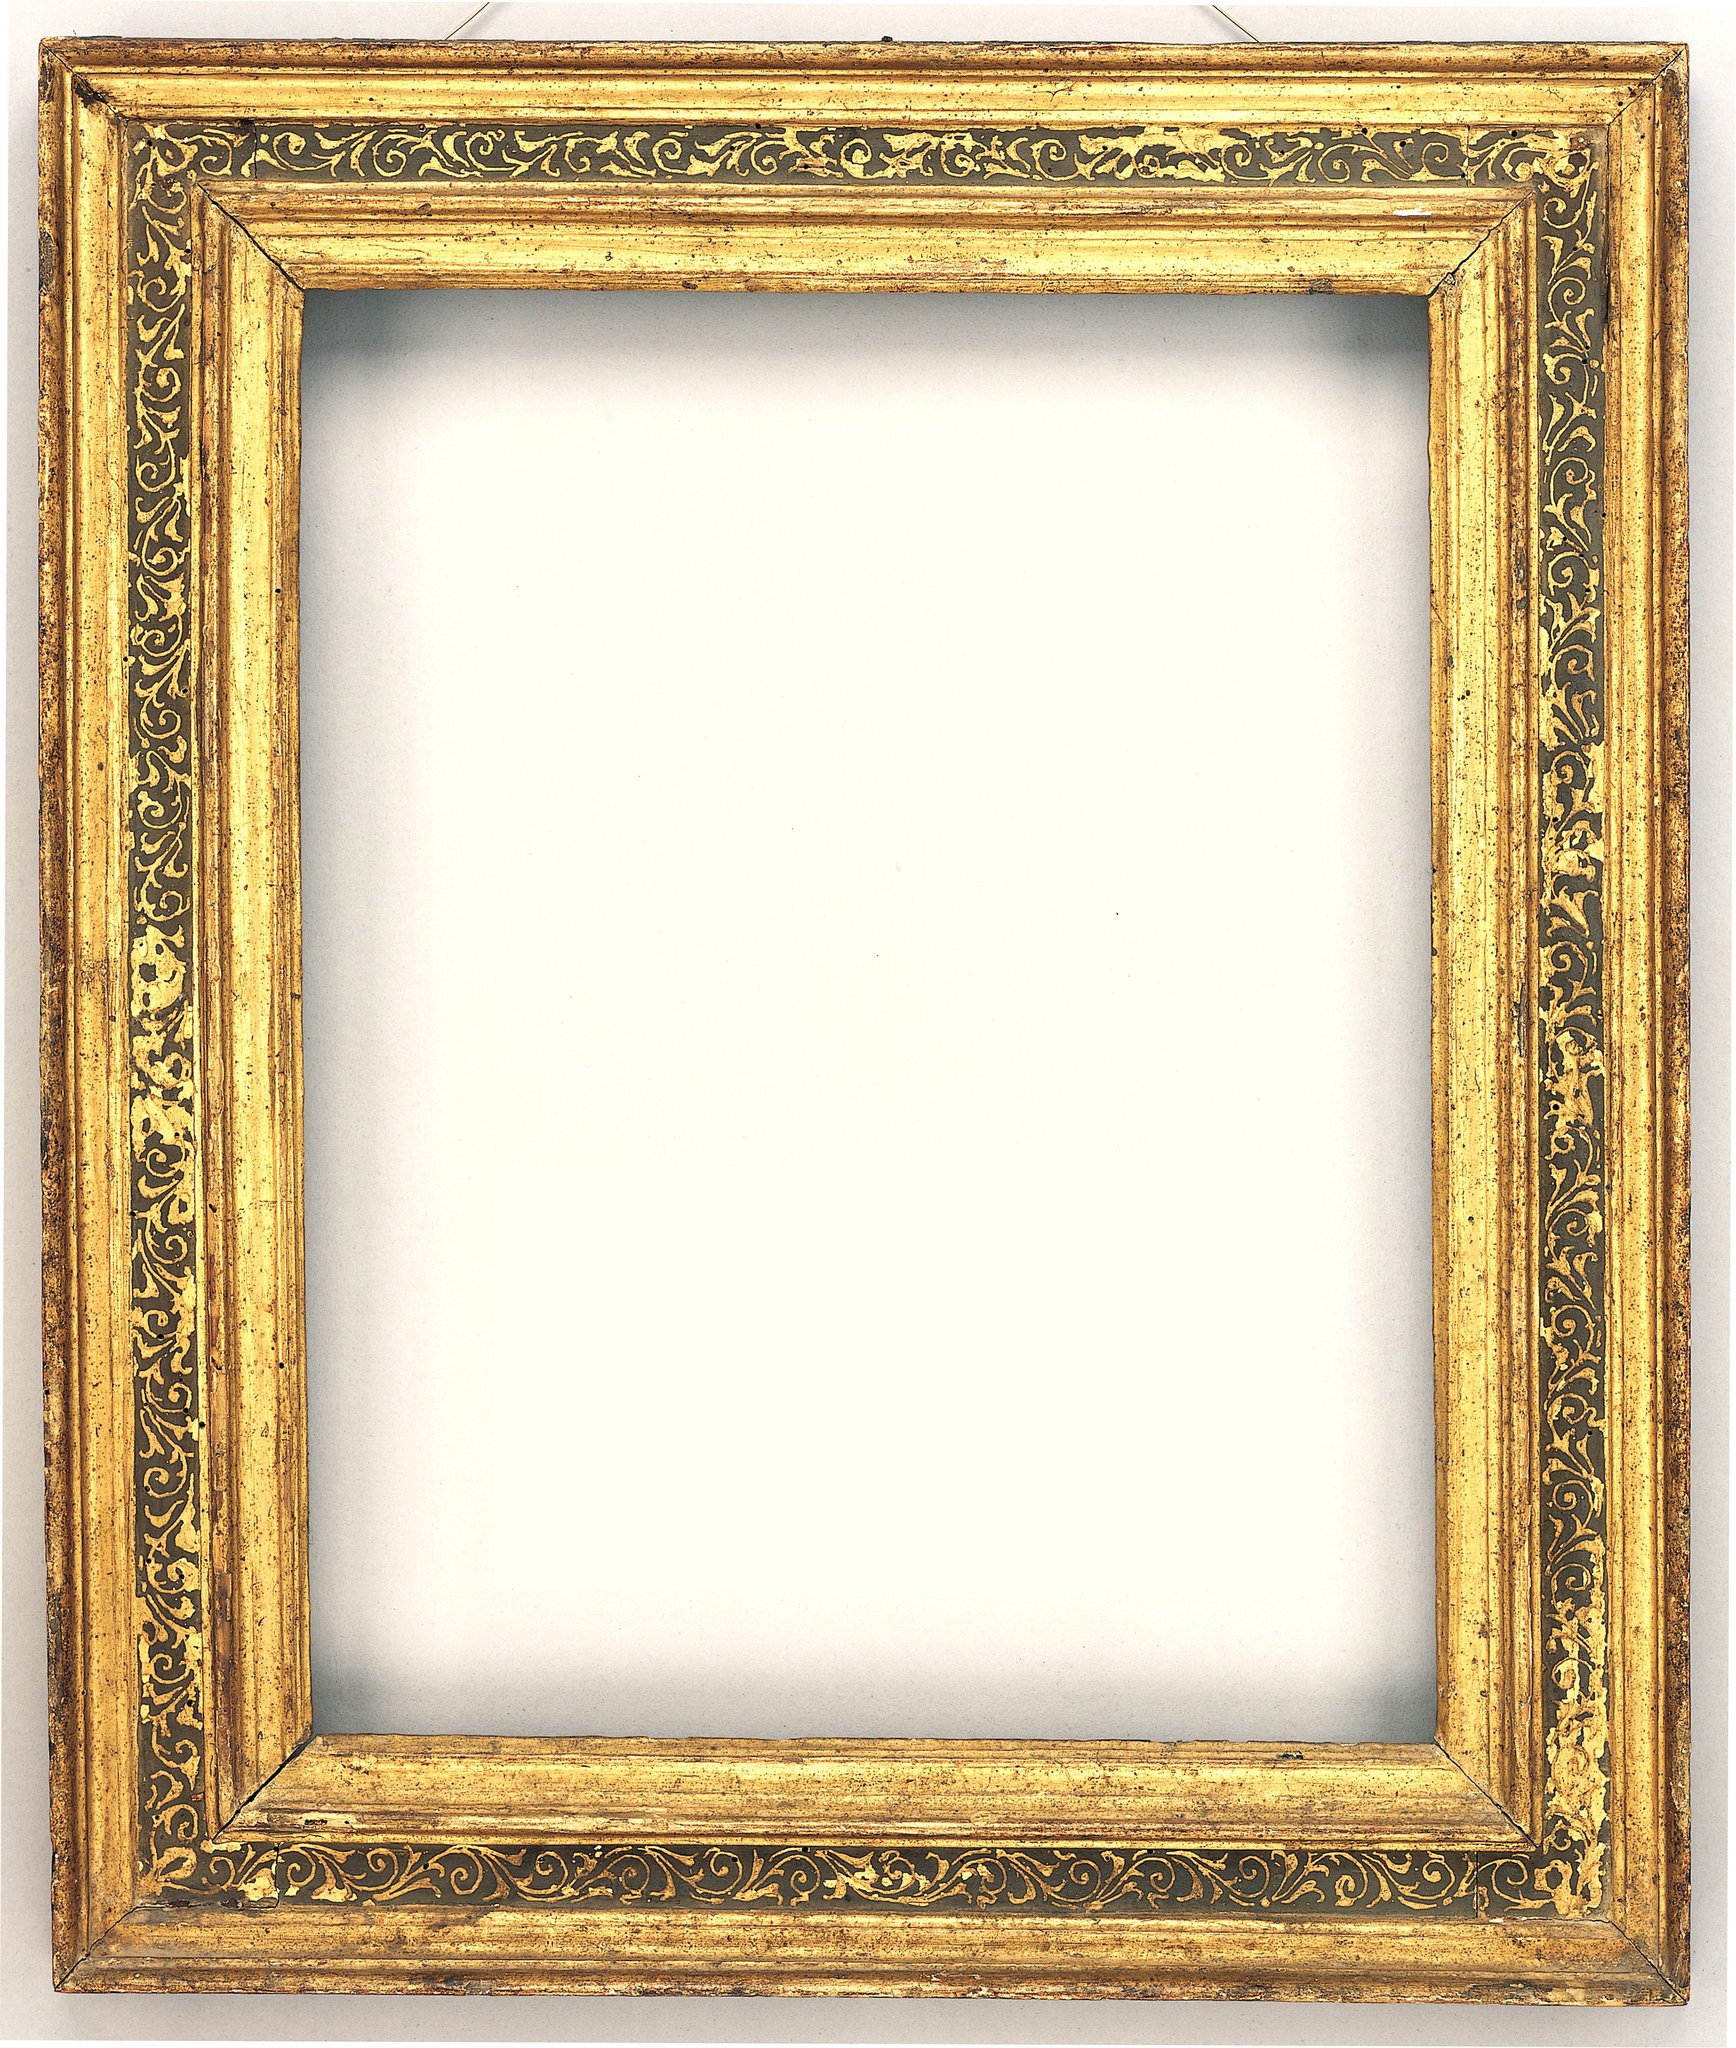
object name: frame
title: Cassetta frame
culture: italian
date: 1534-1566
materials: gilt, wood